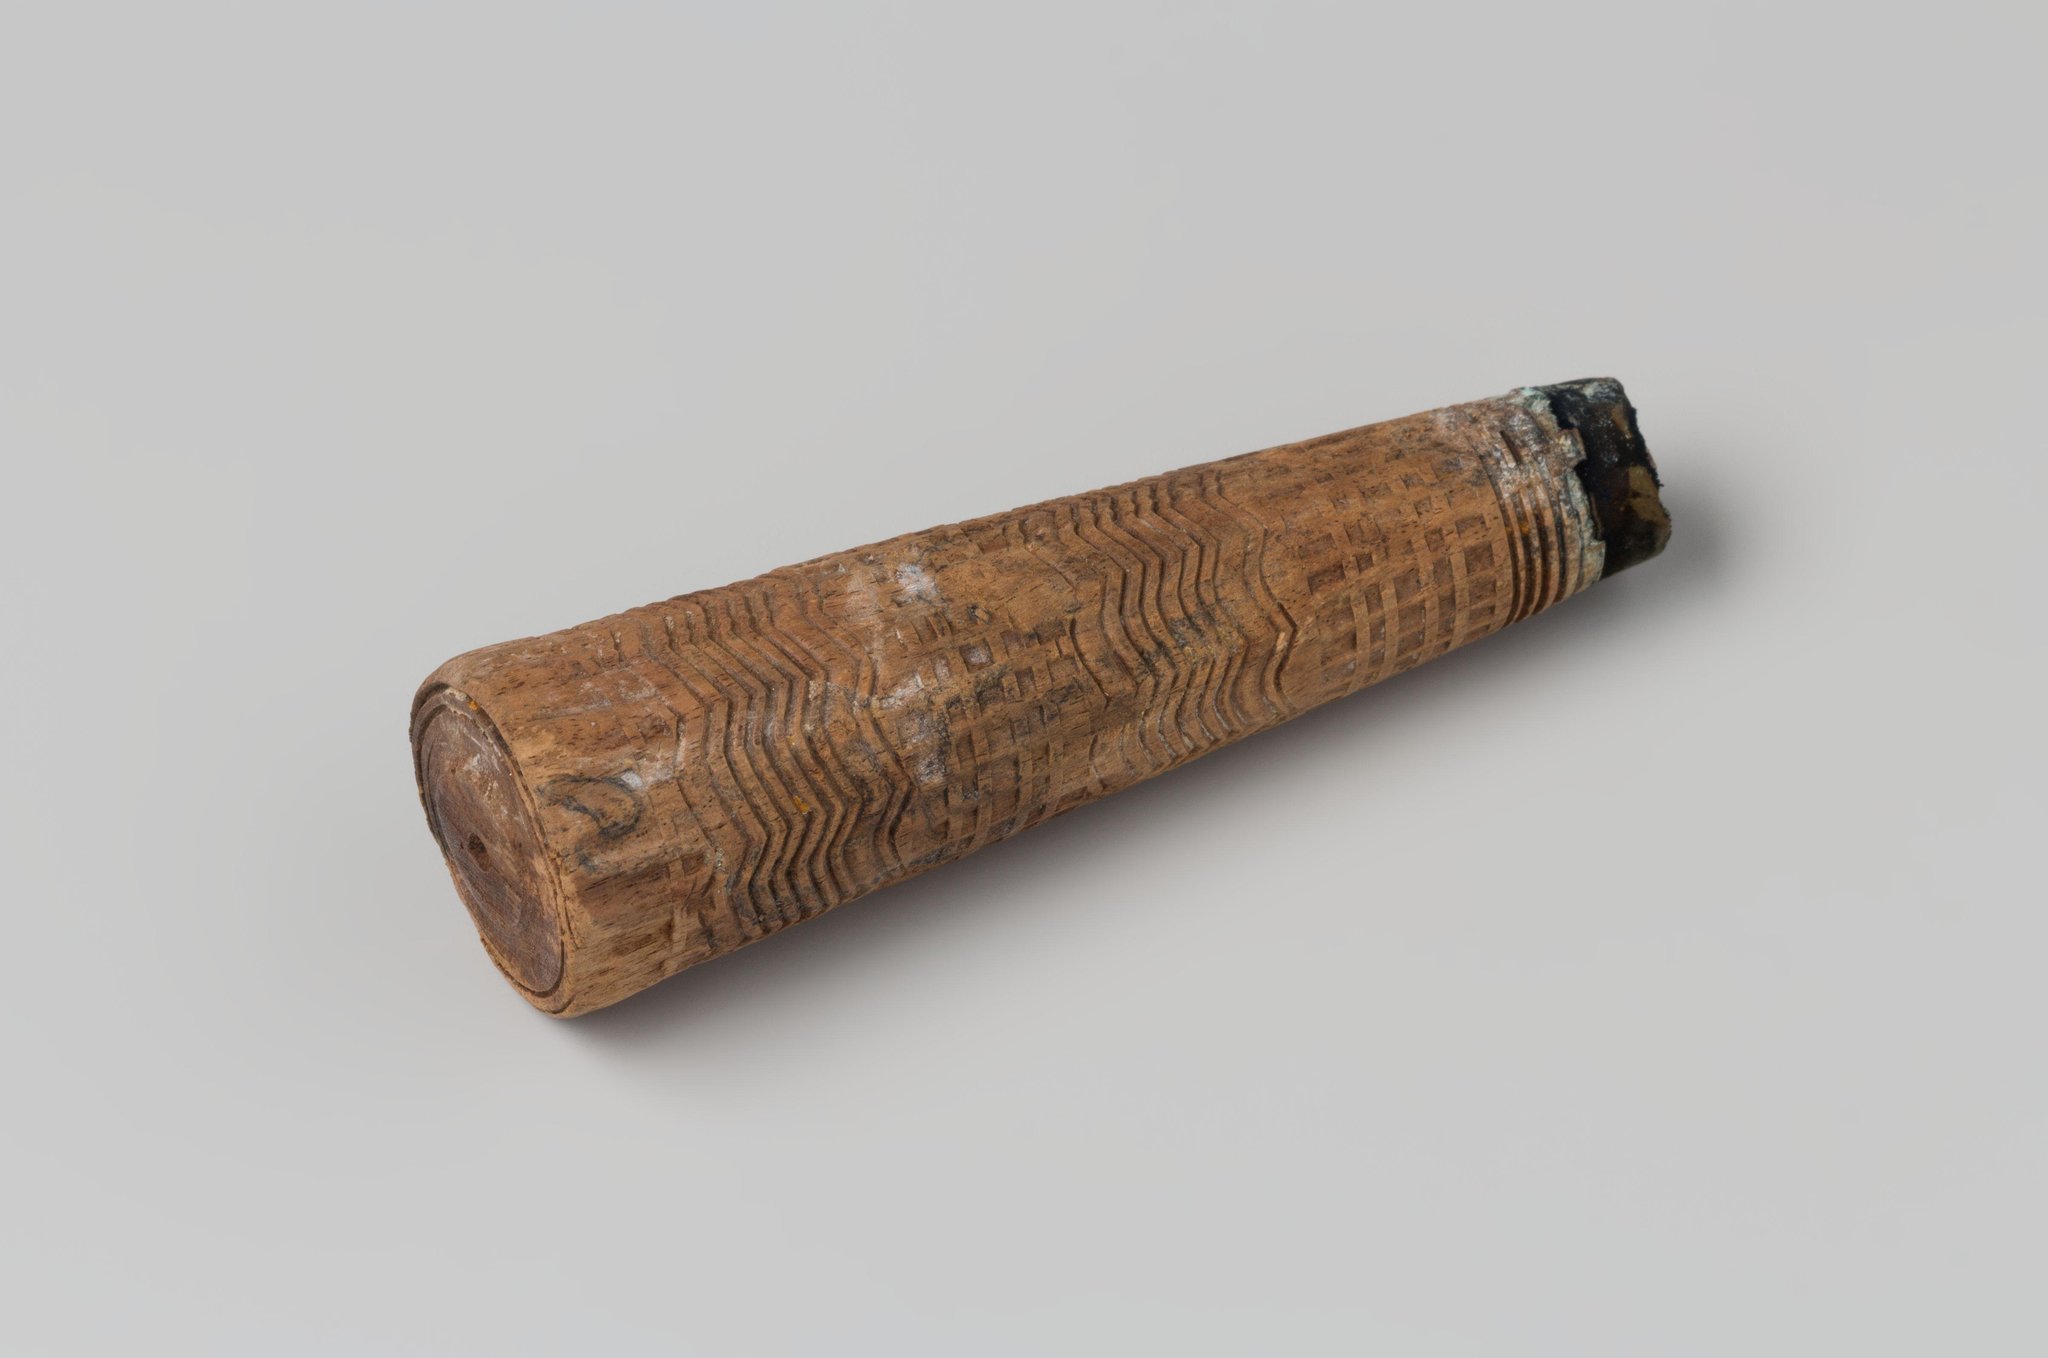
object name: knife handle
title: Messenheft uit het wrak van de Oost-Indiëvaarder Hollandia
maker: Anonymous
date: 1700-1743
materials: copper, wood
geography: netherlands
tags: verenigde oostindische compagnie, hollandia (schip), annet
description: Knife, handle, cylindrical: tapering; id. NG 1979-403H, ferrule, NG 1980-27H426.